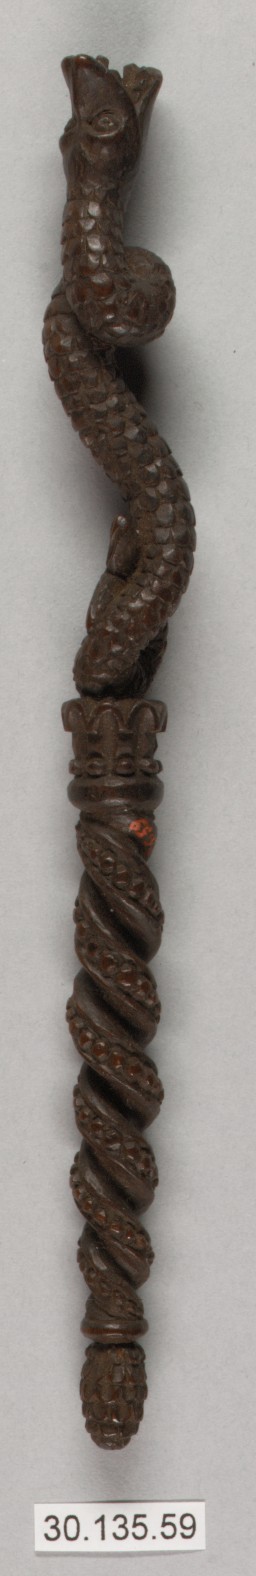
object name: needle sheath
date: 1601-1800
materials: wood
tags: snakes